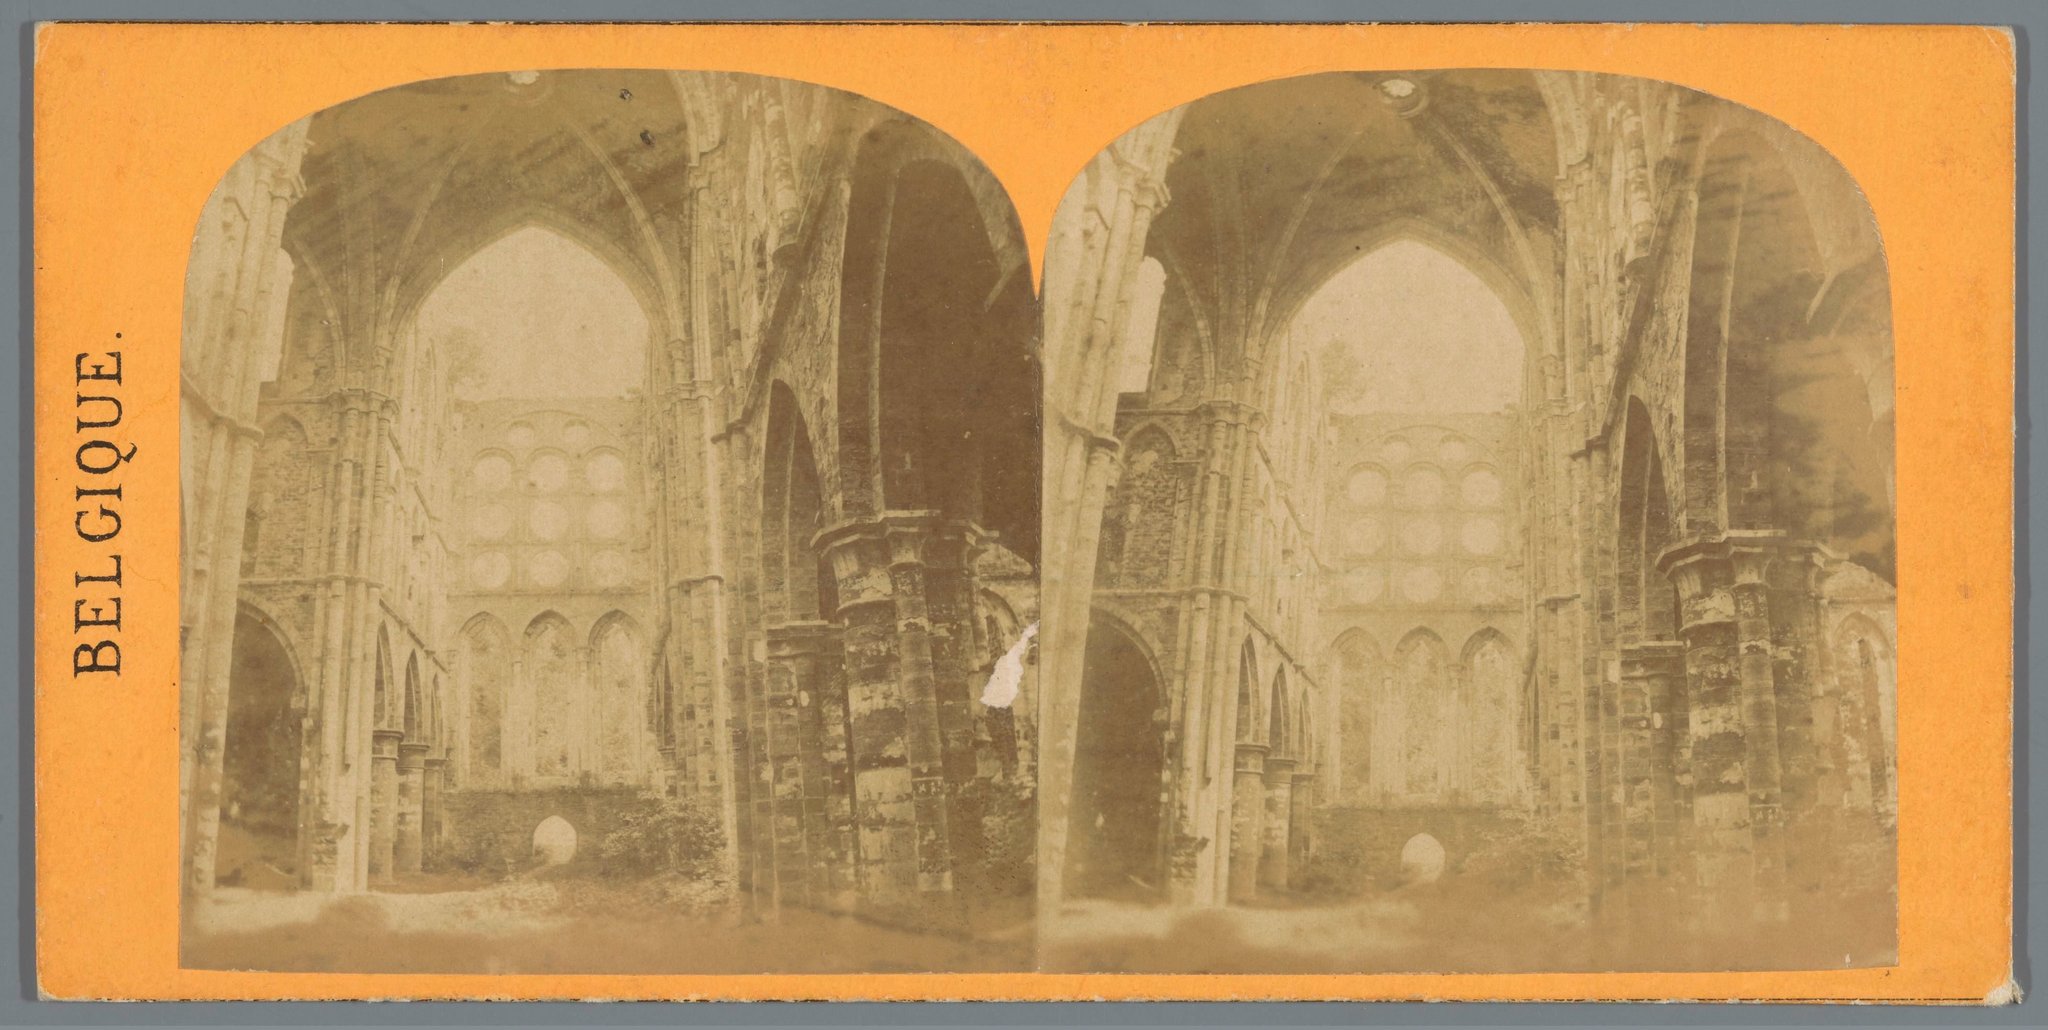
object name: stereograph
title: Een ruïne in Gent, mogelijk de Sint-Baafsabdij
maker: Anonymous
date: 1866-1870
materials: cardboard, paper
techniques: albumen print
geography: villers-la-ville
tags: ruin of church, monastery, etc.